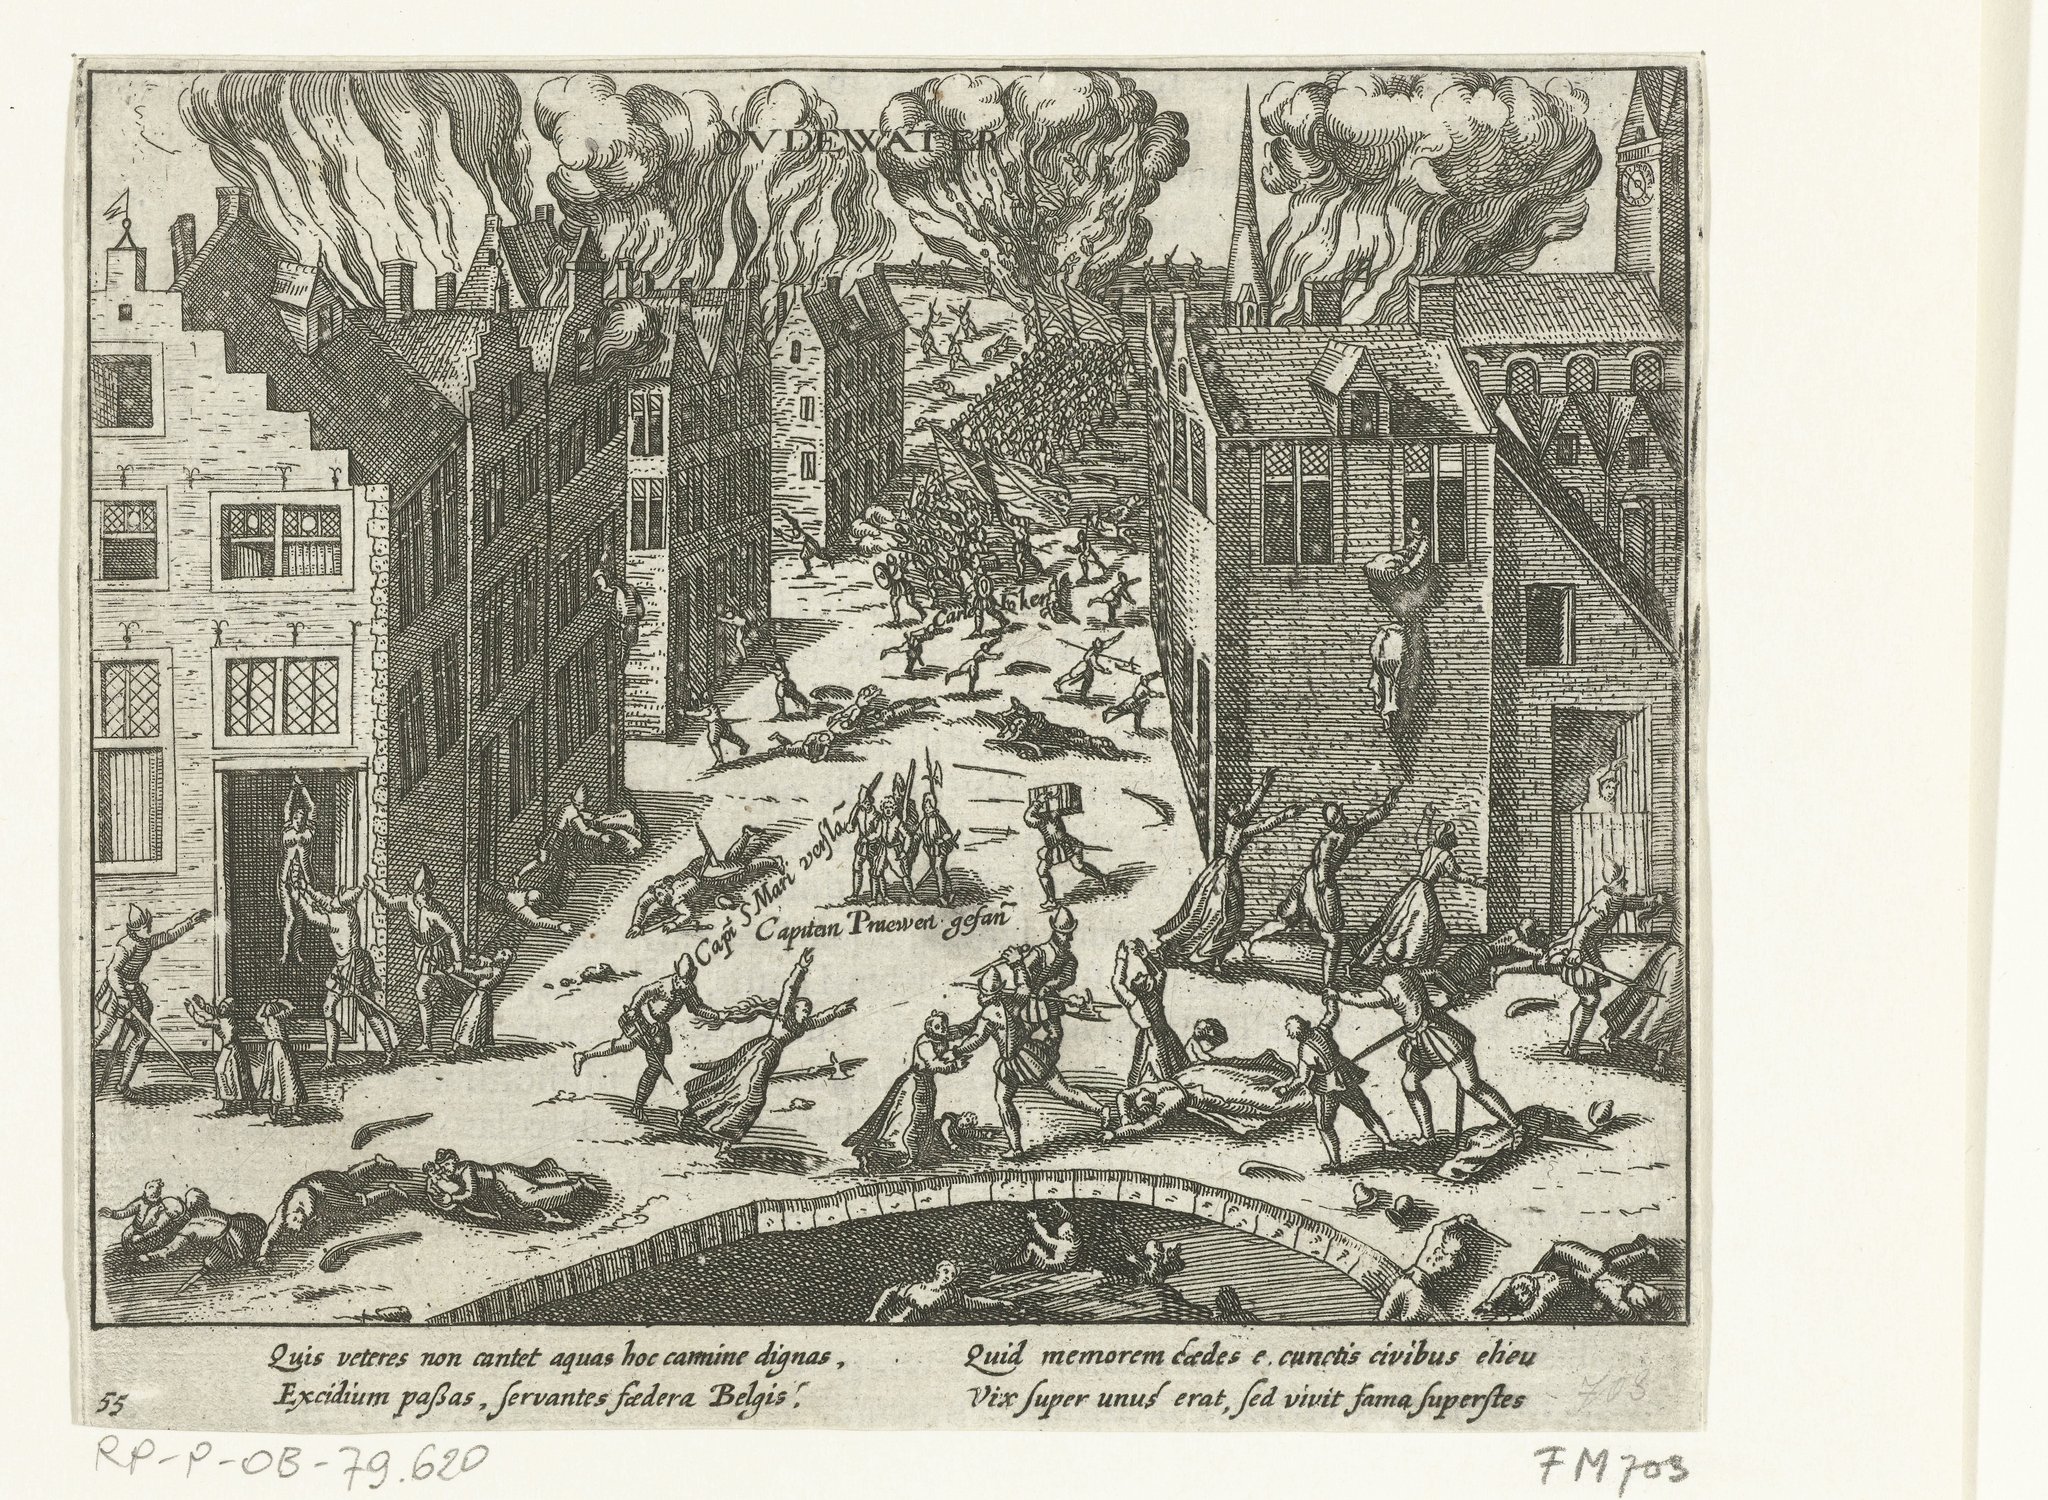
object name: print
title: Moord te Oudewater, 1575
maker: Anonymous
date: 1613-1615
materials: paper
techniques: etching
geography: northern netherlands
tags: maastricht, politician, massacre ~ war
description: Gruwelijke moordpartij aangericht door de Spaanse soldaten op de bevolking van Oudewater, 8 augustus 1575. De stad wordt geplunderd en in brand gestoken door de soldaten onder bevel van Gilles van Hierges. Met onderschrift van 4 regels in het Latijn. Genummerd: 55. Bedrukt op achterzijde met tekst in het Latijn.